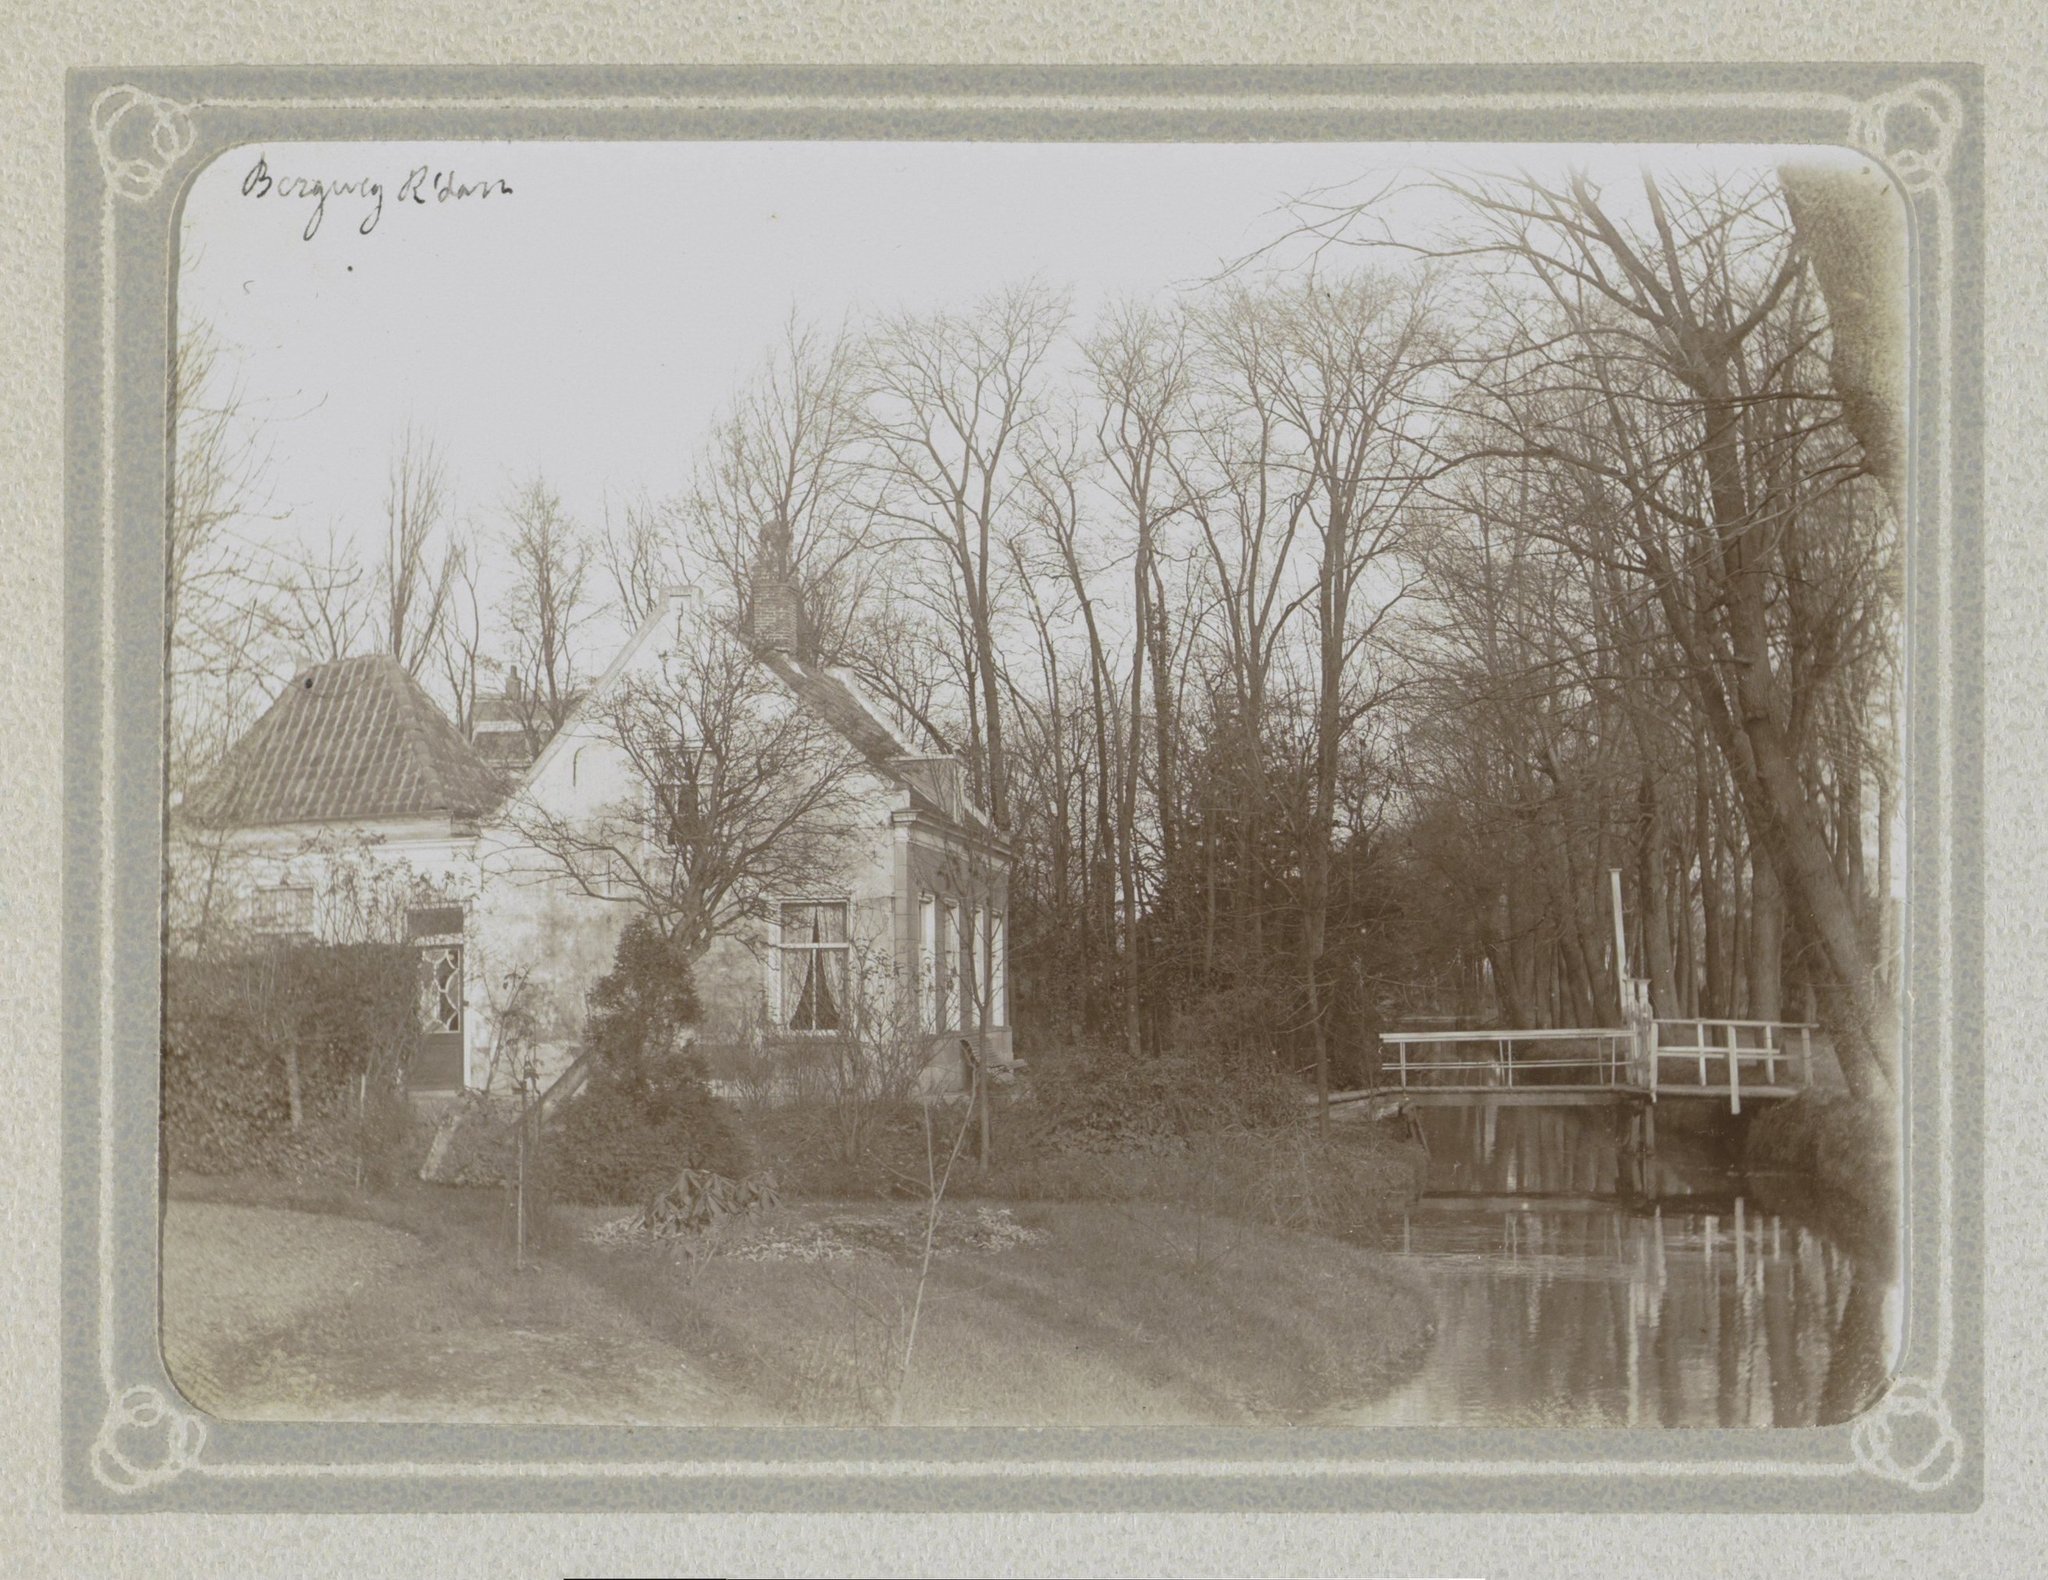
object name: photograph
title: Bergweg R'dam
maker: folkert idzes de jong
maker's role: architect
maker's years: 1877-1929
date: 1905-1907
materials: photographic support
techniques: collodion silver print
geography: rotterdam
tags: rural housing, e.g. country-house, villa, cottage, village, bridge, small canal, ditch, rotterdam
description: Onderdeel van Topografisch album van Nederlandse dorpen en steden 1905.